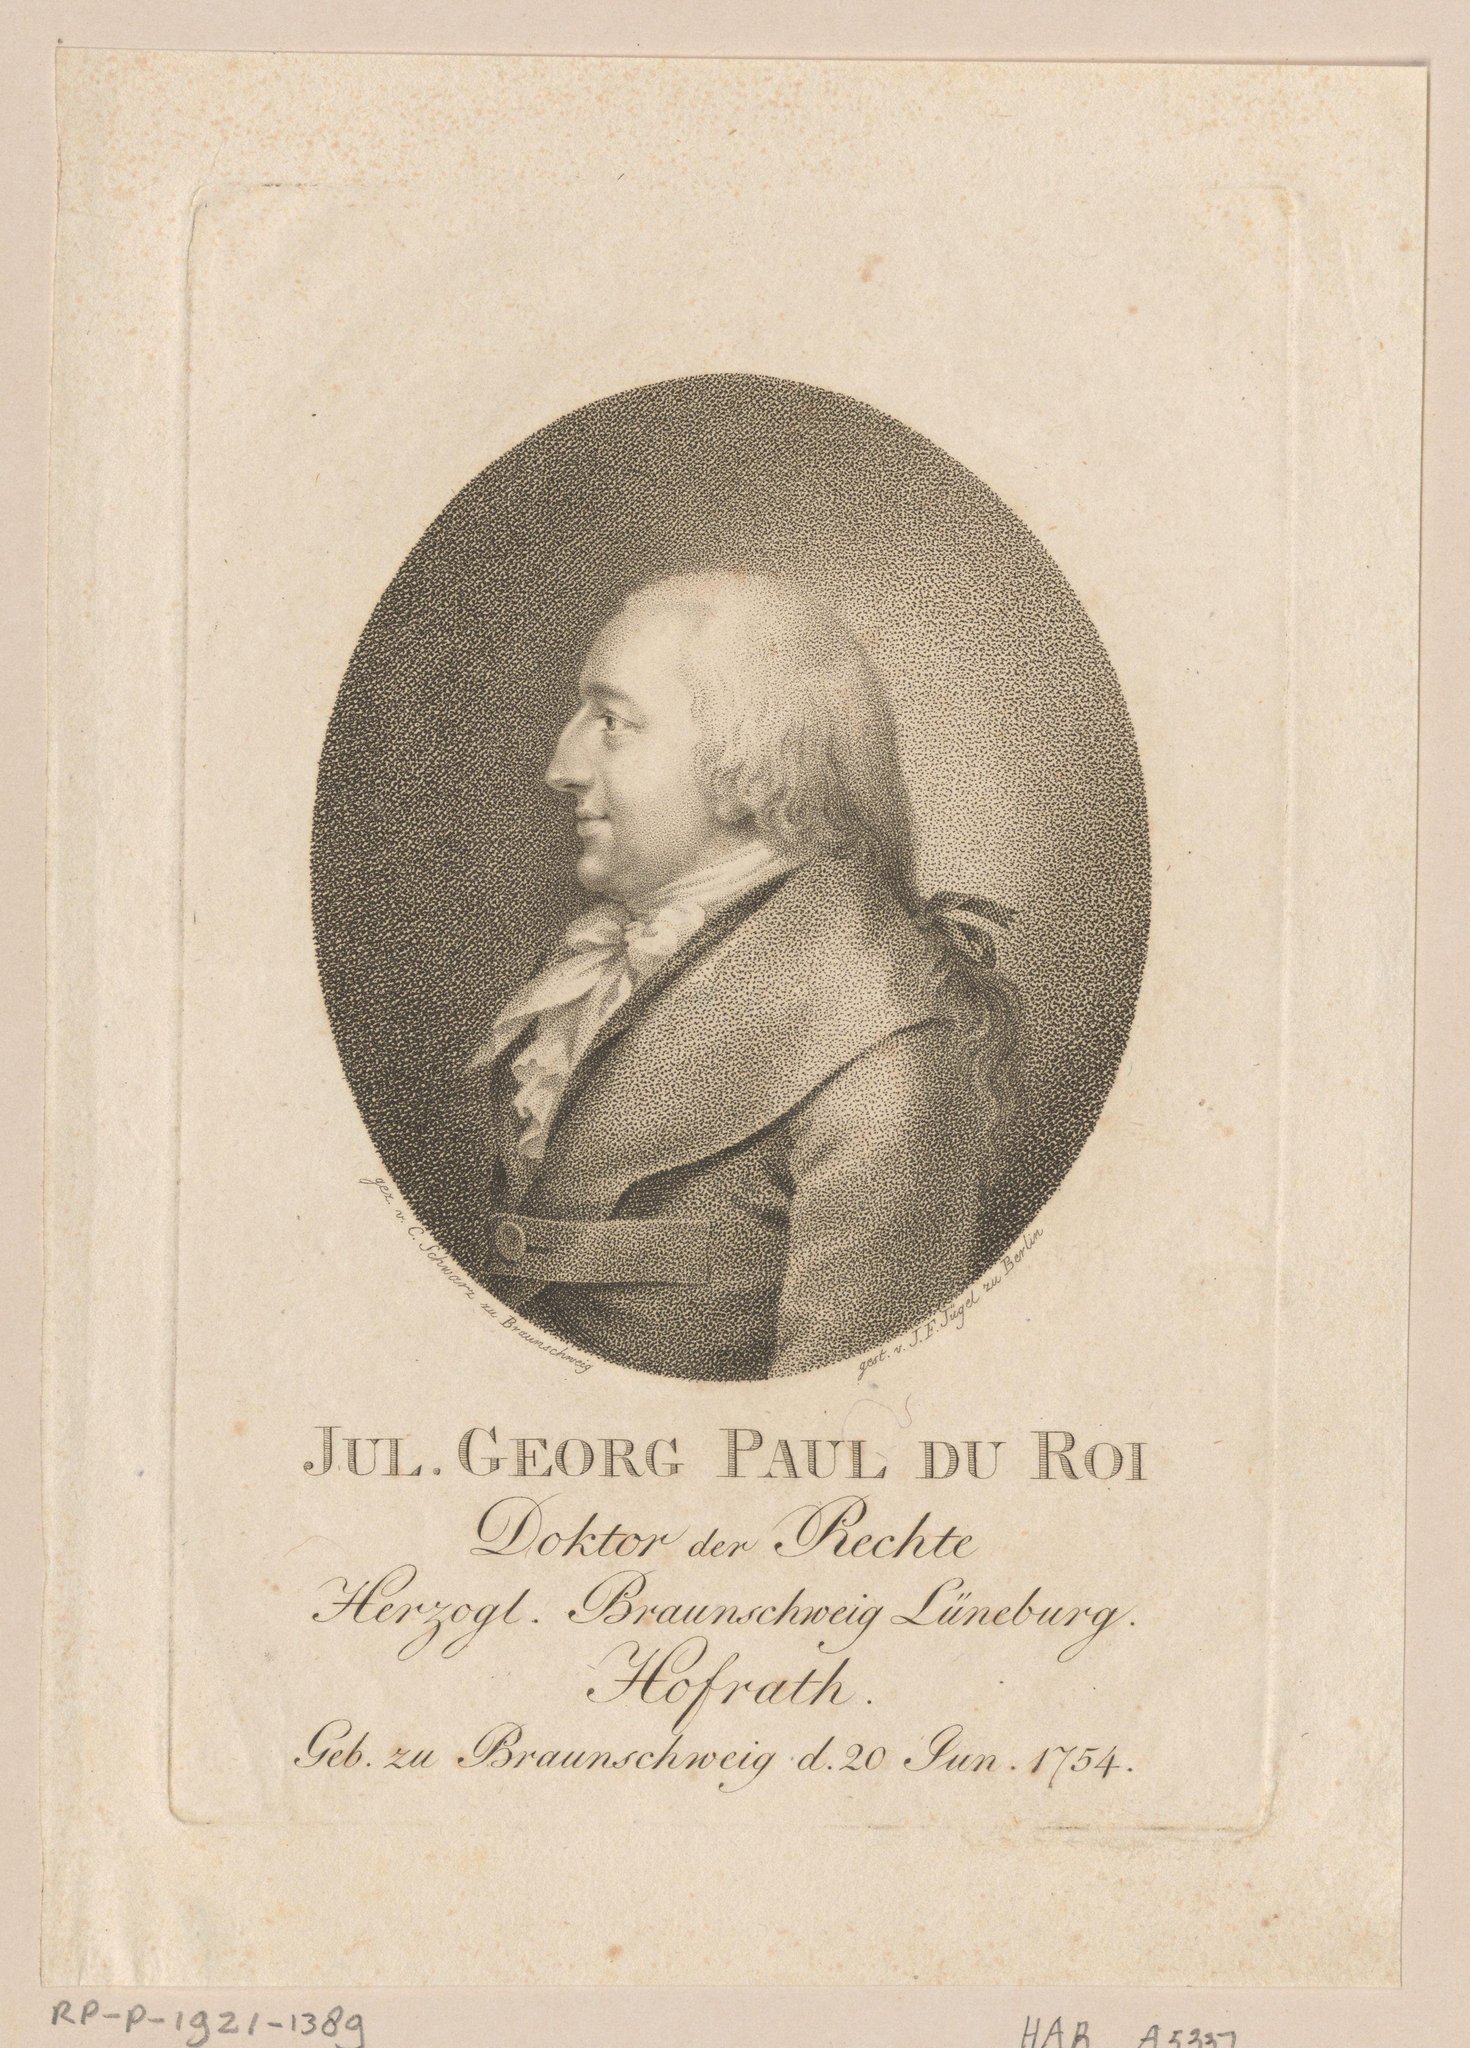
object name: print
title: Portret van Julius Georg Paul Du Roi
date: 1797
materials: paper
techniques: engraving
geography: braunschweig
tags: historical persons, law and jurisprudence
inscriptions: collector's mark: Lugt 2233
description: Prent mogelijk uit: Neue allgemeine Deutsche Bibliothek. Kiel: Carl Ernst Bohn, 1797, dl. 31.